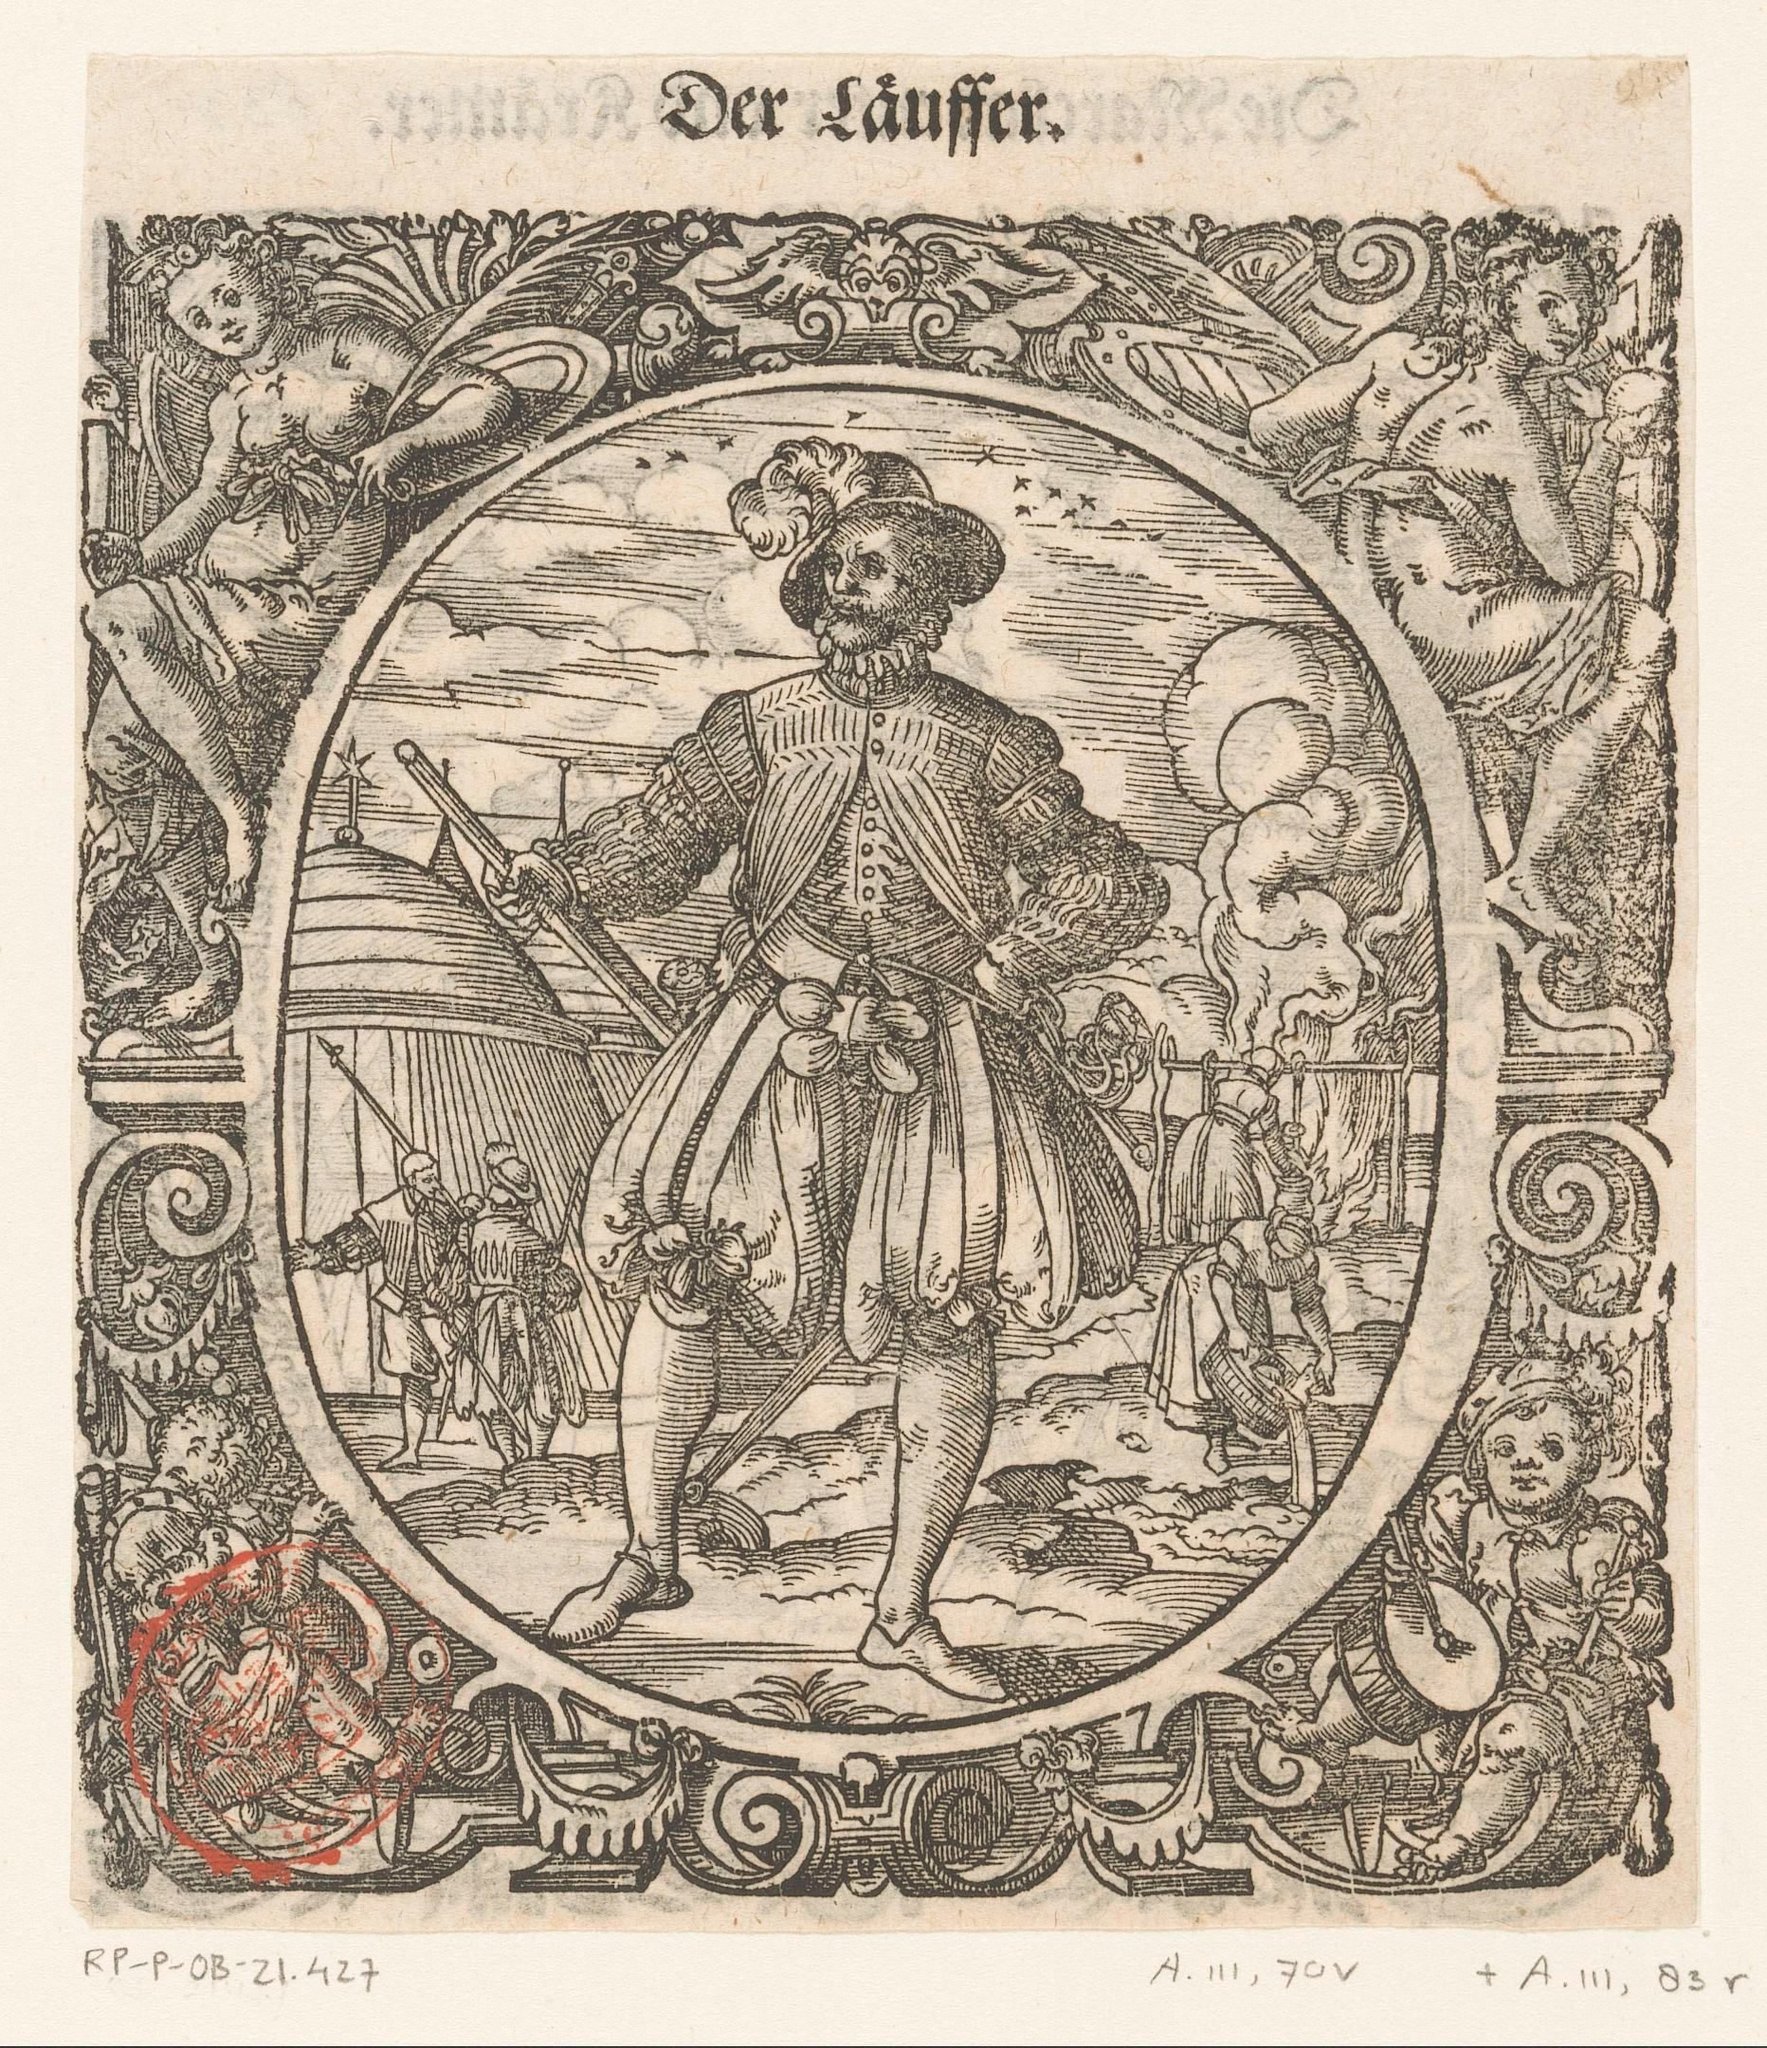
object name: print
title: Der Läuffer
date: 1573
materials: paper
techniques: woodcut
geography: nuremberg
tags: warfare; military affairs, the soldier; the soldier's life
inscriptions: collector's mark: Lugt 240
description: Zowel de voorstelling als de ornamentrand werd gebruikt voor verschillende edities van Leonhardt Fronspergers Kriegsbuch.